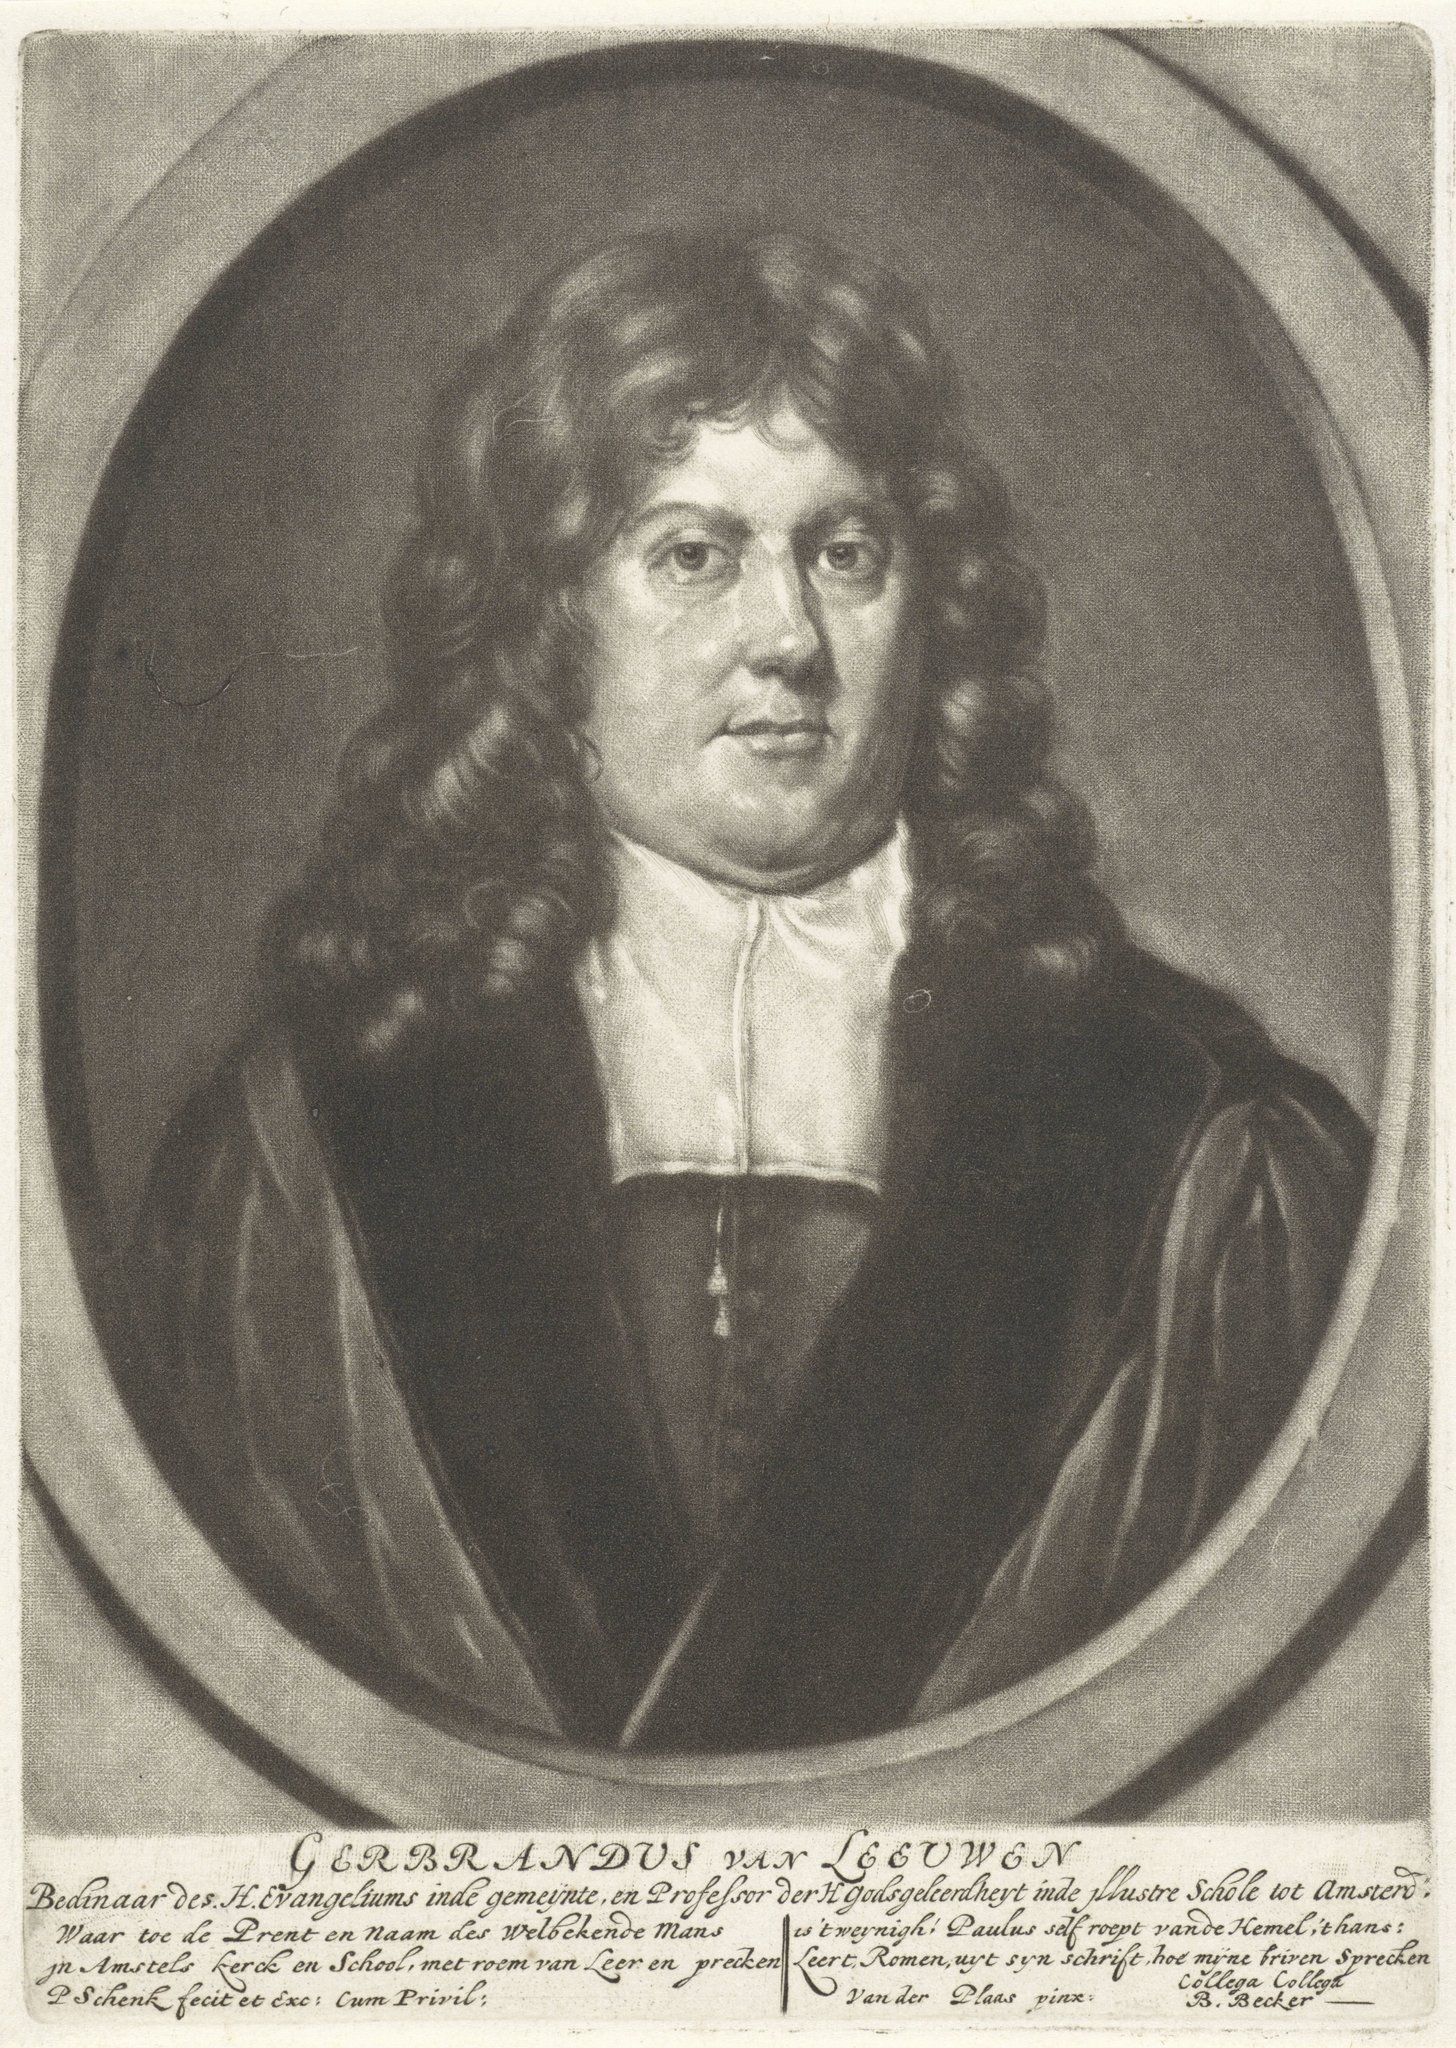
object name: print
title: Portret van Gerbrand van Leeuwen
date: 1686-1713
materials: paper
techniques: engraving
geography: amsterdam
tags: hoogleraar, gerbrand van leeuwen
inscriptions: collector's mark: Lugt 2228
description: De predikant en hoogleraar Gerbrand van Leeuwen.